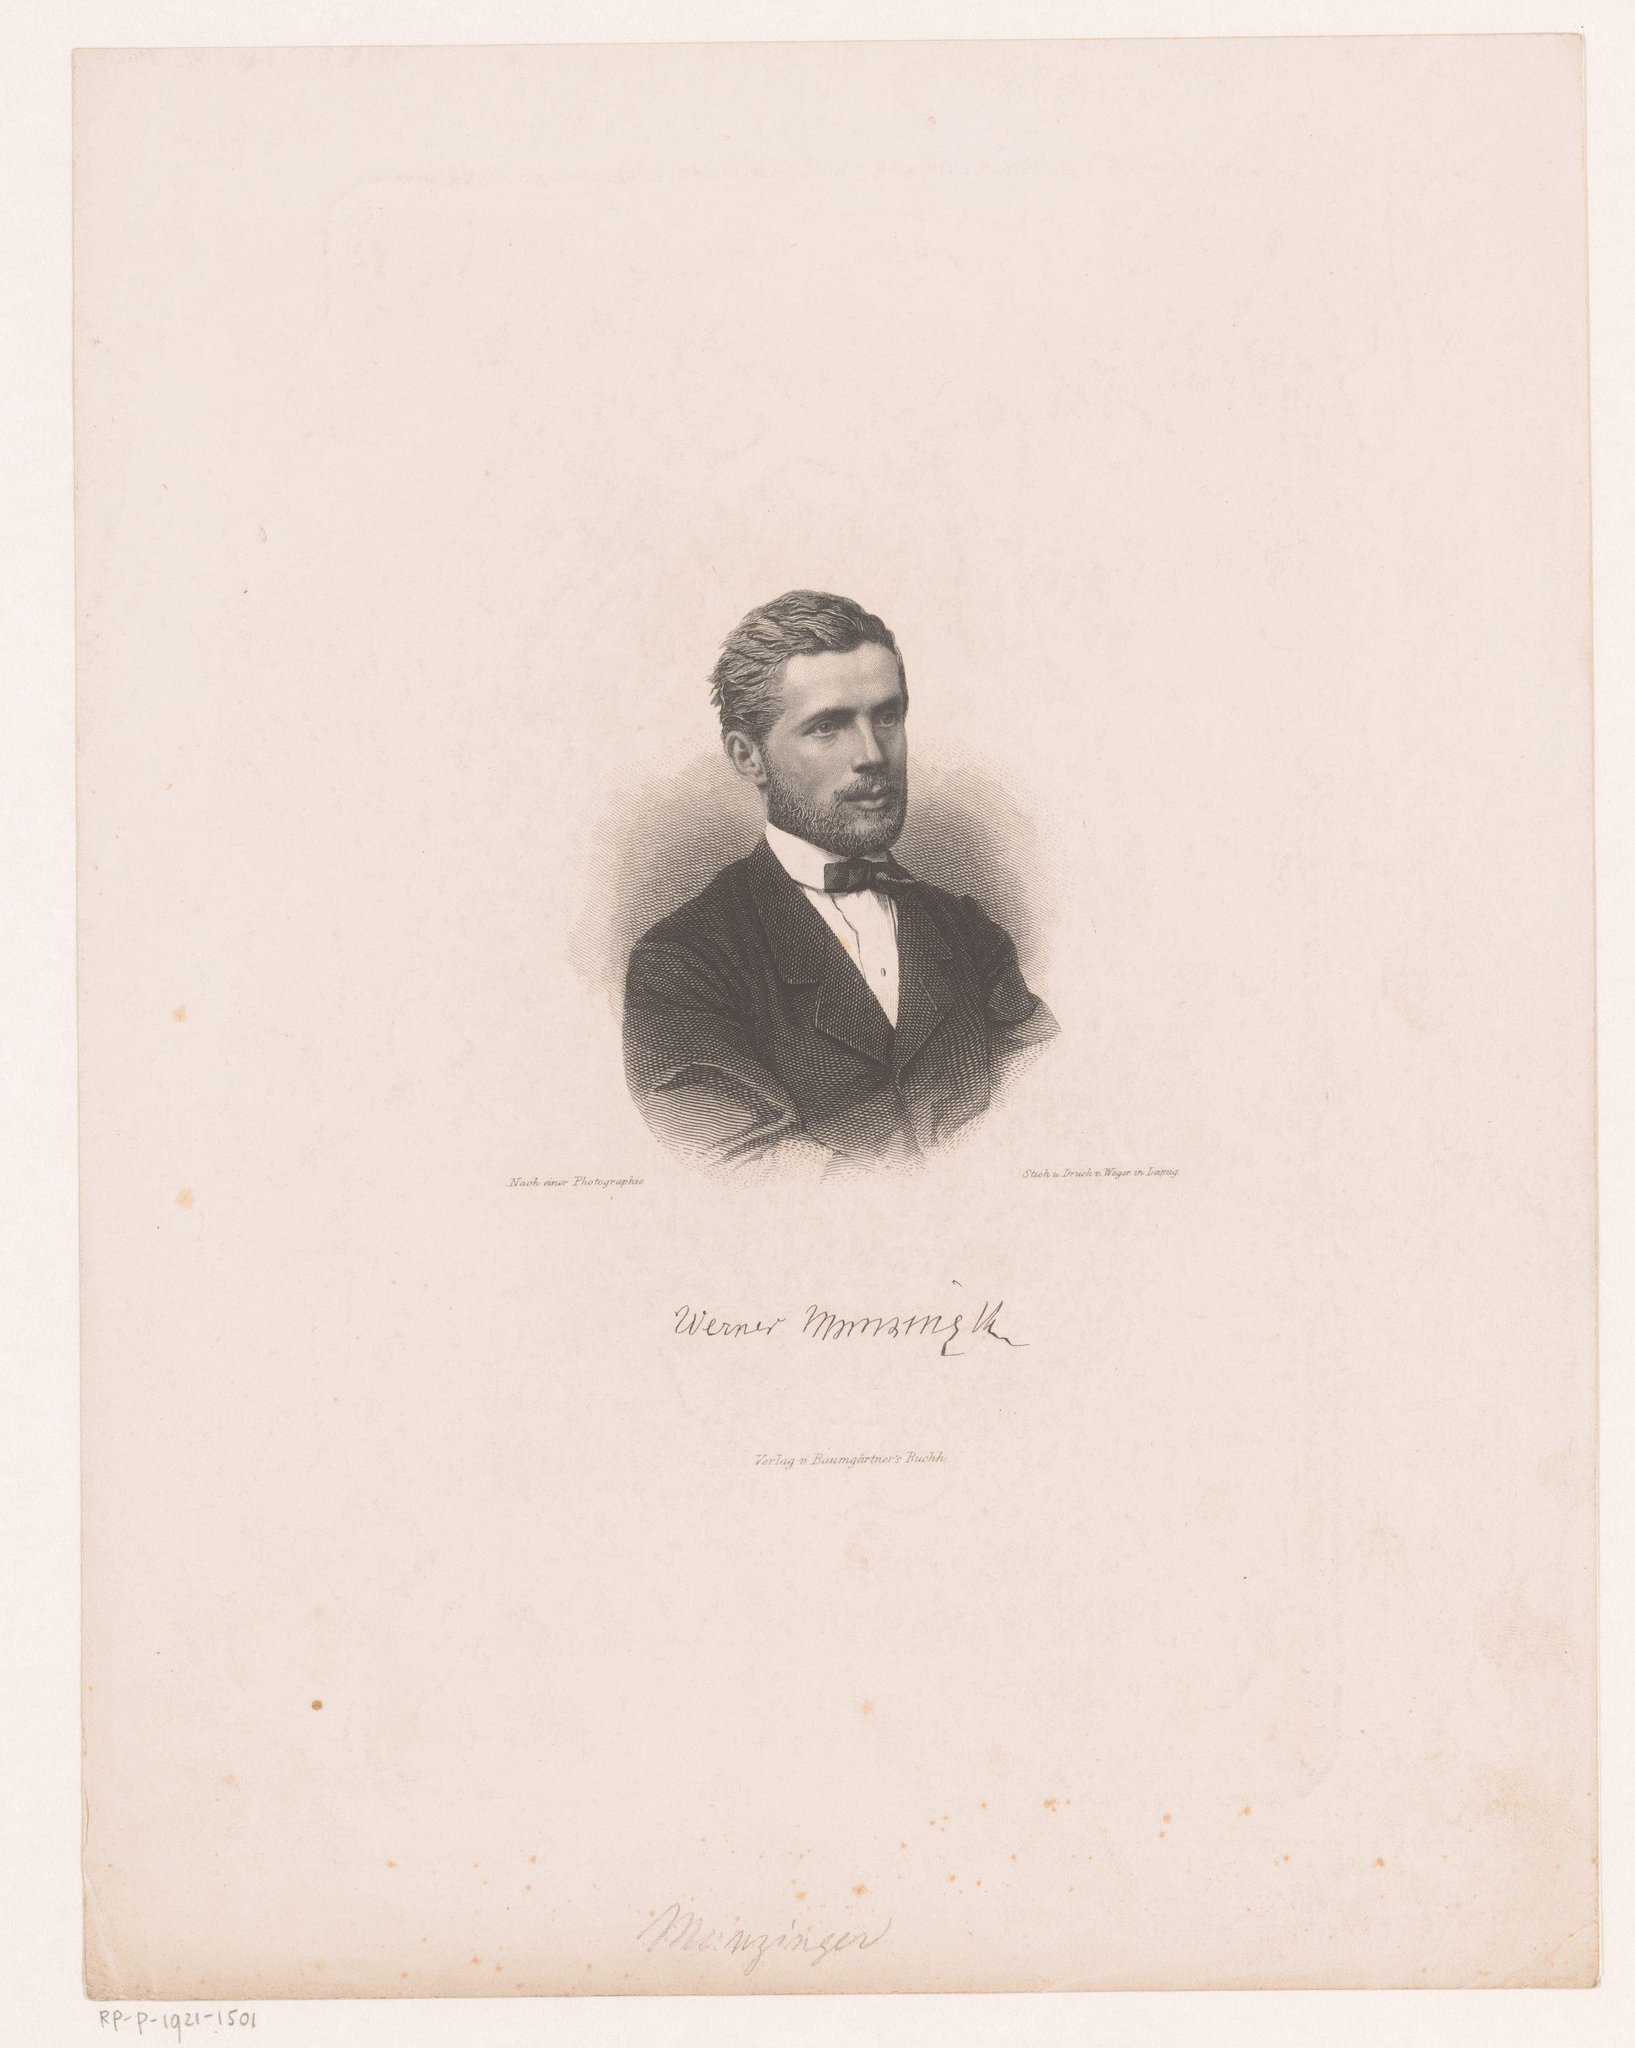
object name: print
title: Portret van Werner Munzinger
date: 1865-1892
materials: paper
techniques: engraving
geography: leipzig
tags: switzerland, historical persons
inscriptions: collector's mark: Lugt 2228